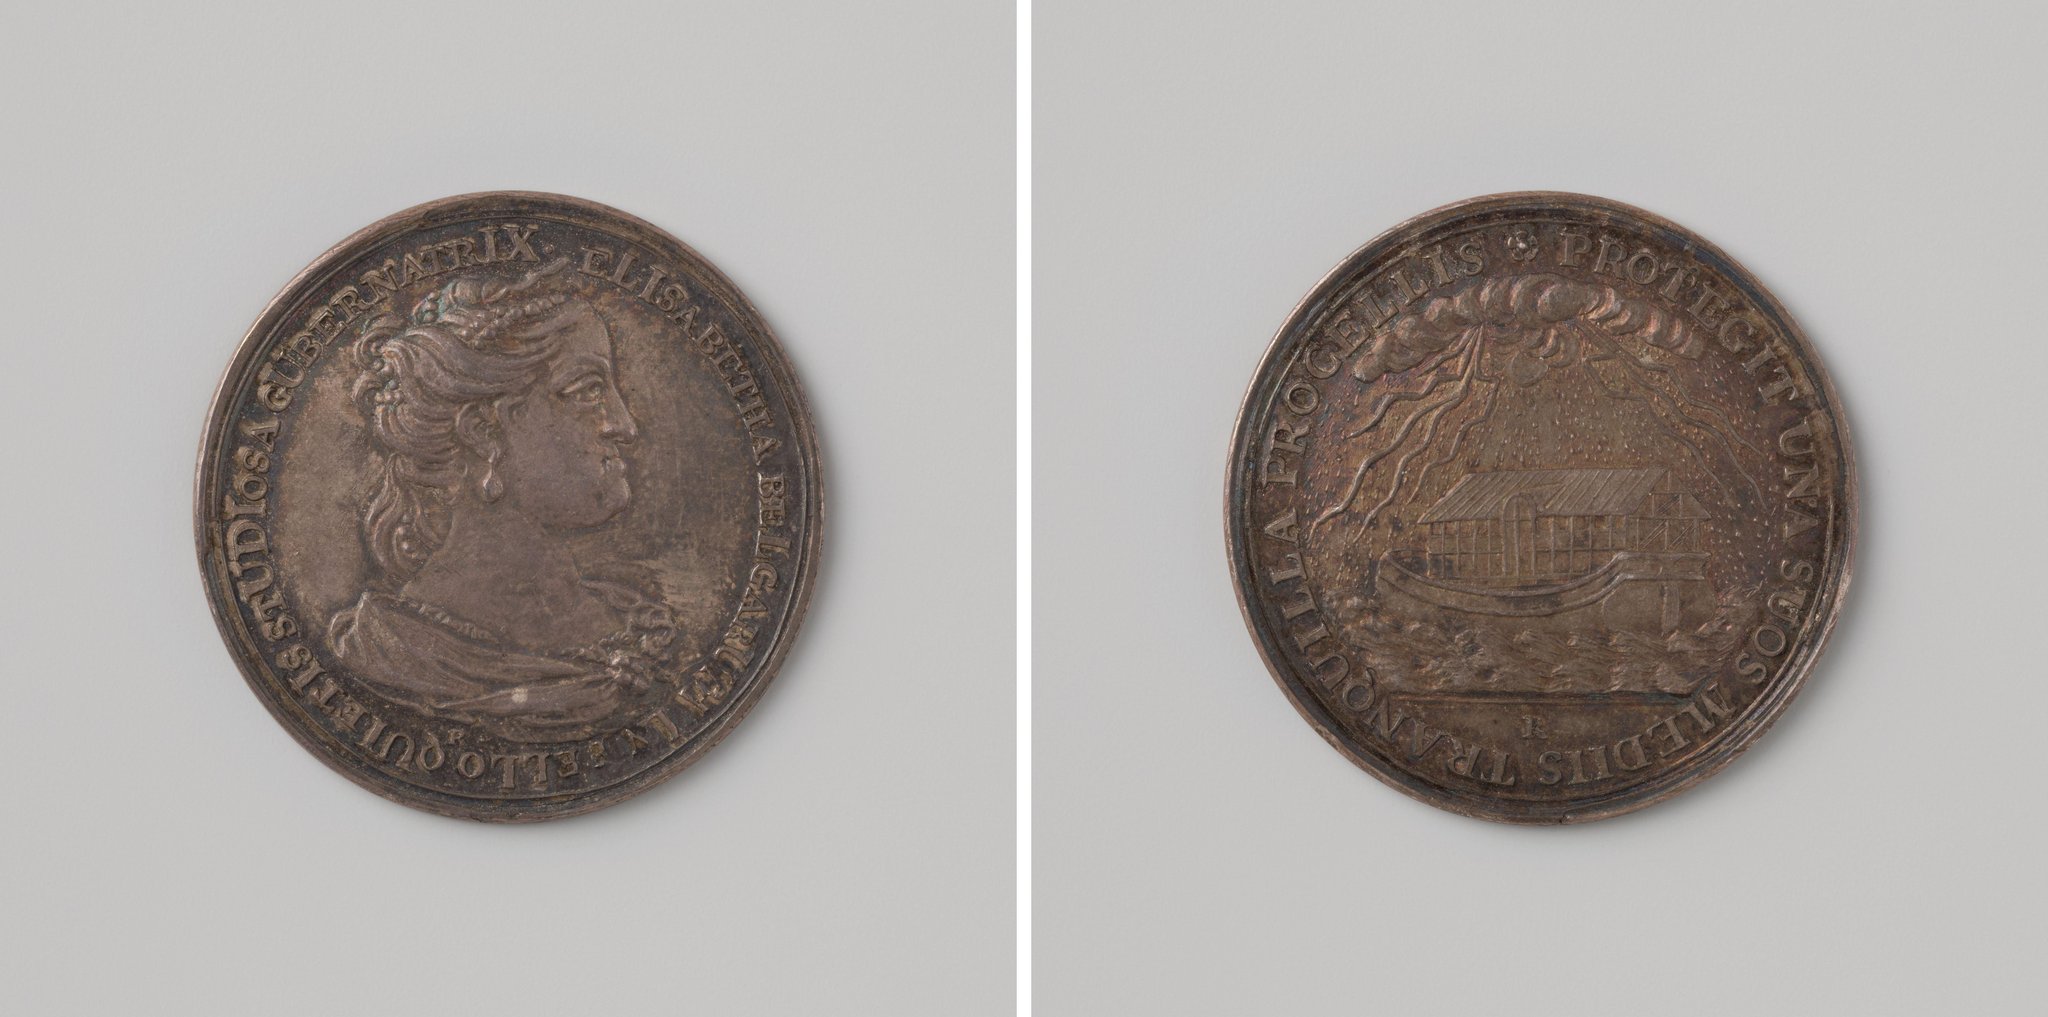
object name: new year medal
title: Handhaven van de vrede door Maria Elisabeth, landvoogdes der zuidelijke Nederlanden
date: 1736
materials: silver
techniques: striking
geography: antwerp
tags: maria elisabeth (aartshertogin van oostenrijk)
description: Zilveren penning. Voorzijde: borststuk vrouw met diadeem binnen omschrift. Keerzijde: ark van Noah tijdens onweer binnen omschrift